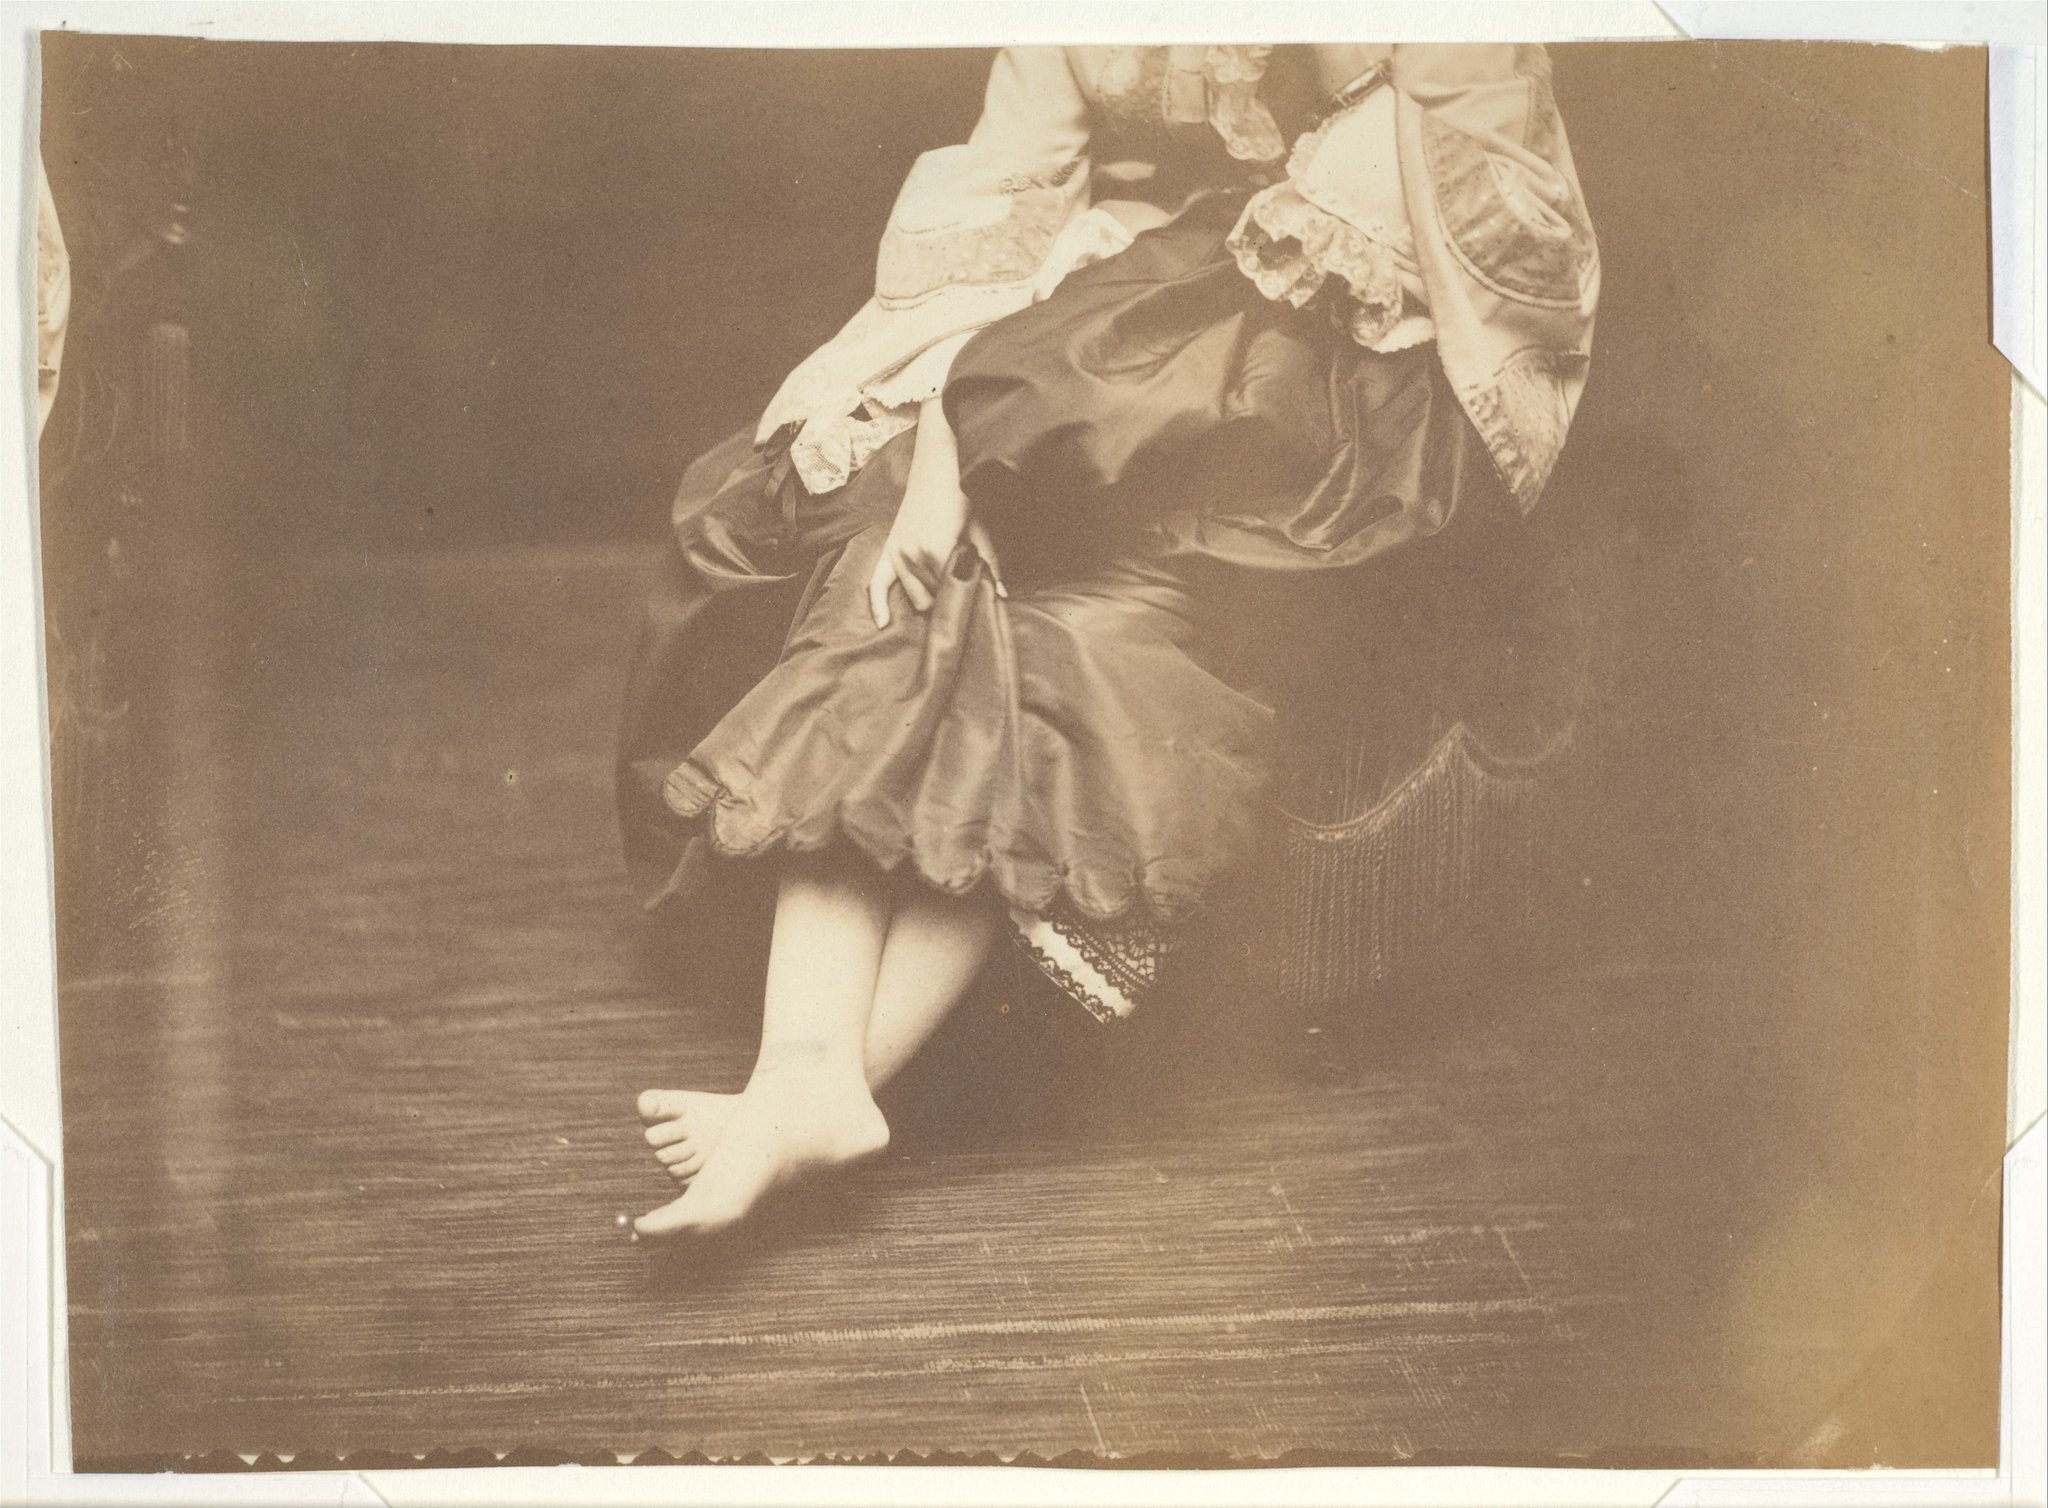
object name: photograph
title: Les jambes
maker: pierre-louis pierson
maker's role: artist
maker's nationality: french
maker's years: 1822-1913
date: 1860-1869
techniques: albumen silver print, glass negative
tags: feet